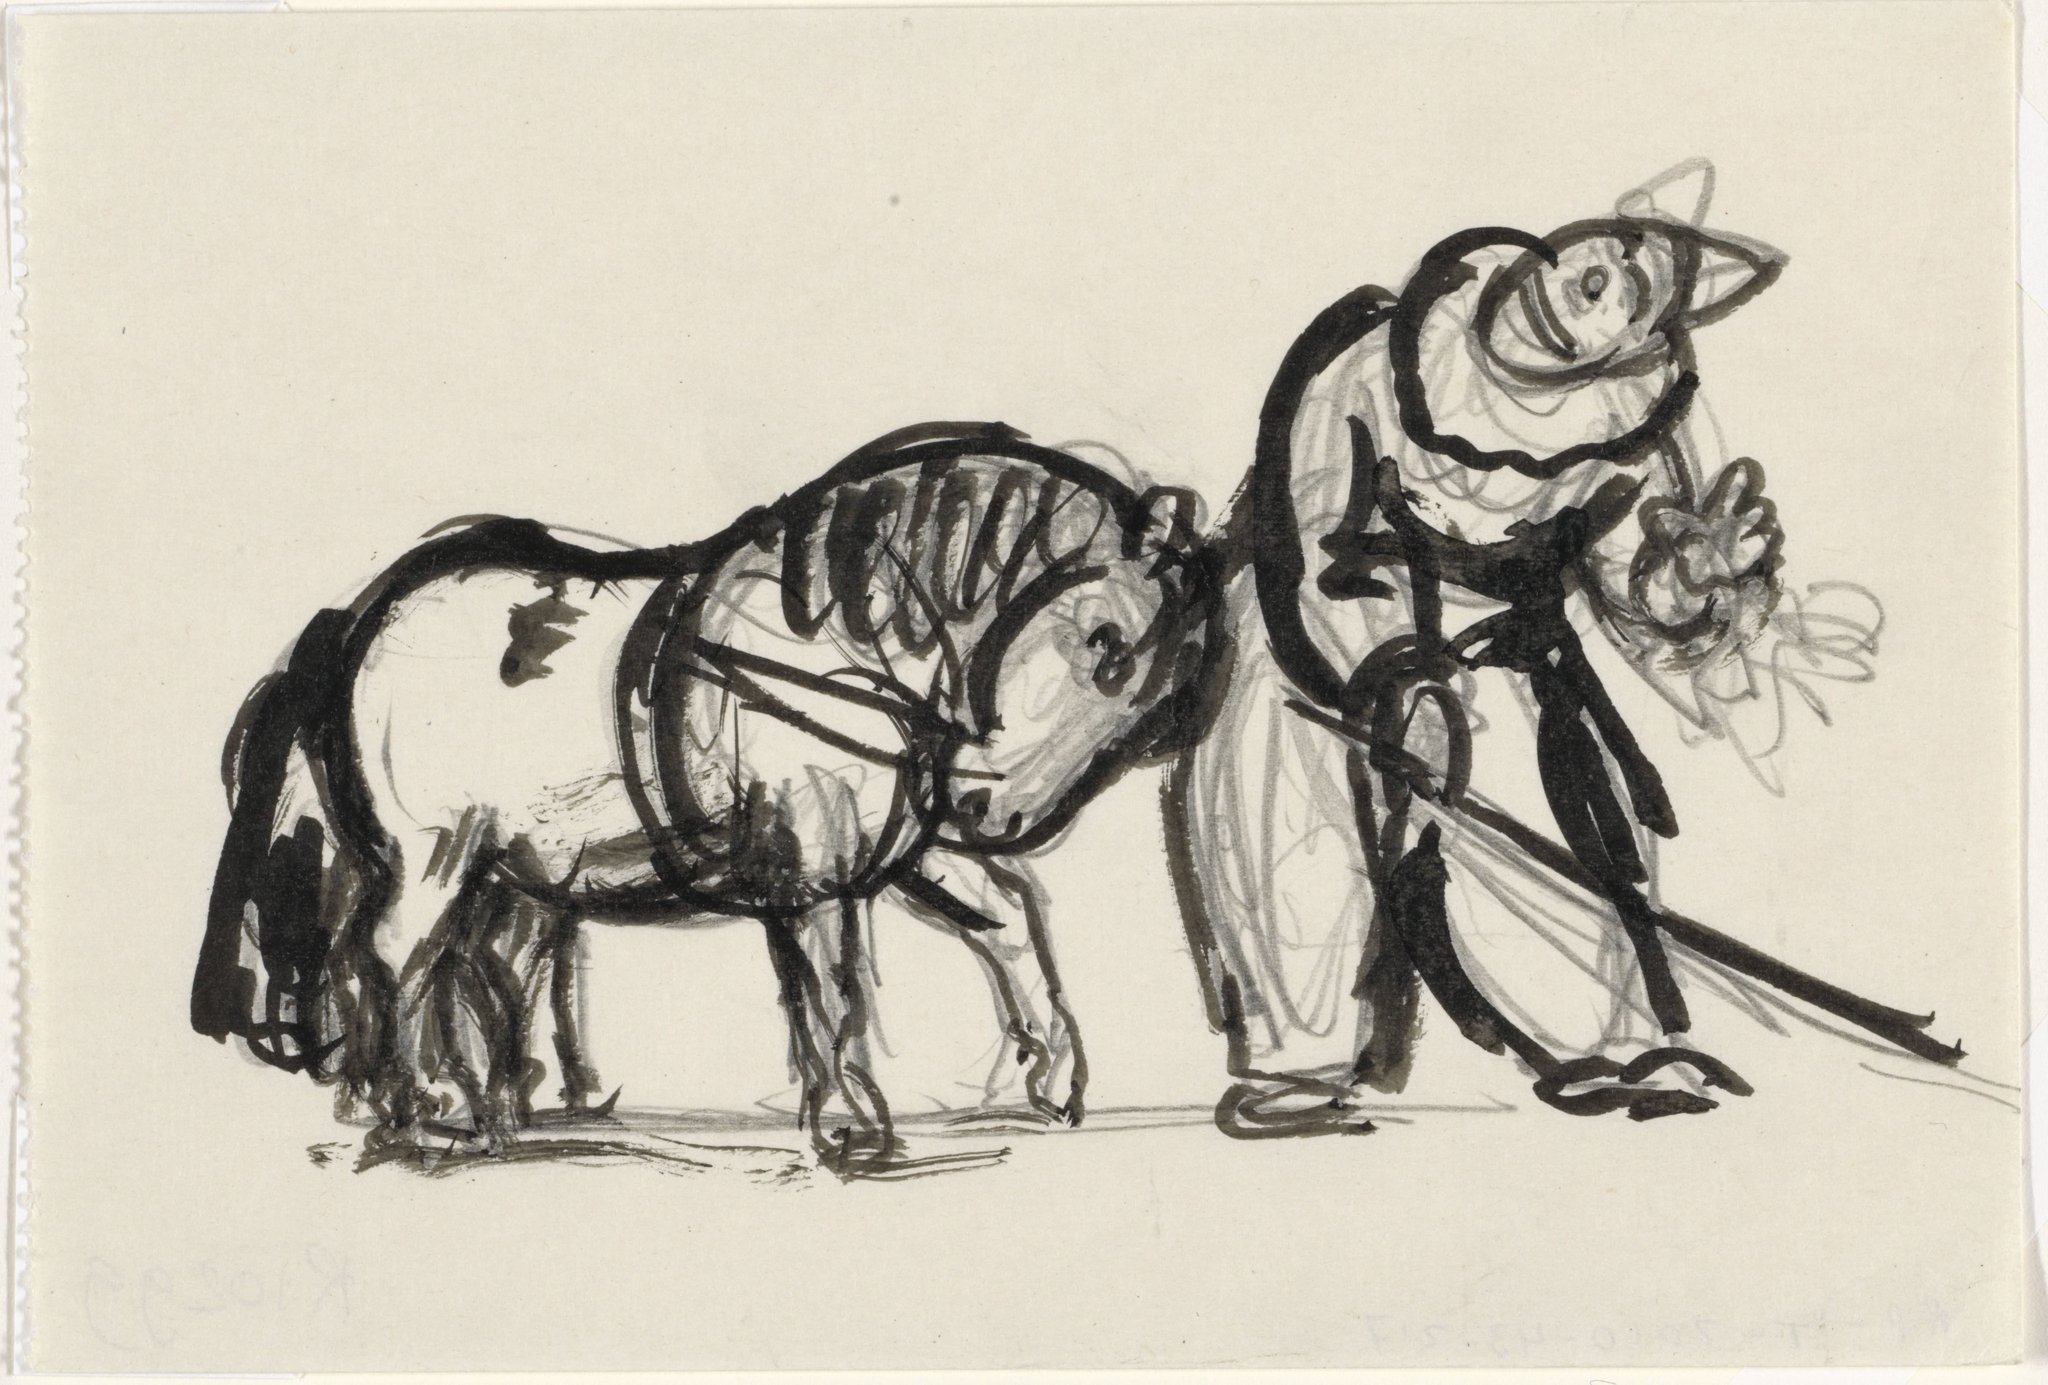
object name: drawing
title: Zonder titel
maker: leo gestel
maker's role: draughtsman, print maker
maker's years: 1881-1941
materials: ink, paper, pencil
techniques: brush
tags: types in 'commedia dell'arte': pierrot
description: Pierrot met zweep rechts, dresseert een pony met hoofdstel links (en profil).